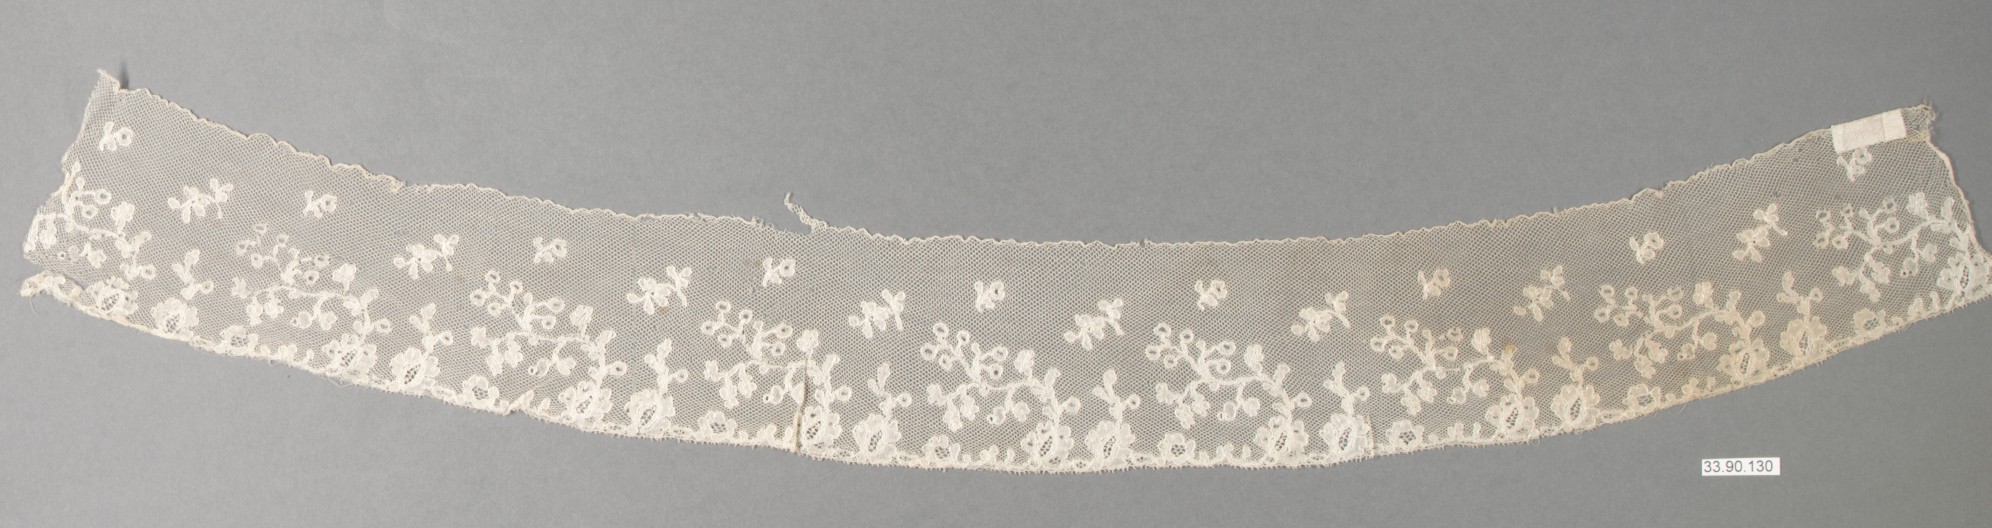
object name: edging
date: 1750-1800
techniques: lace